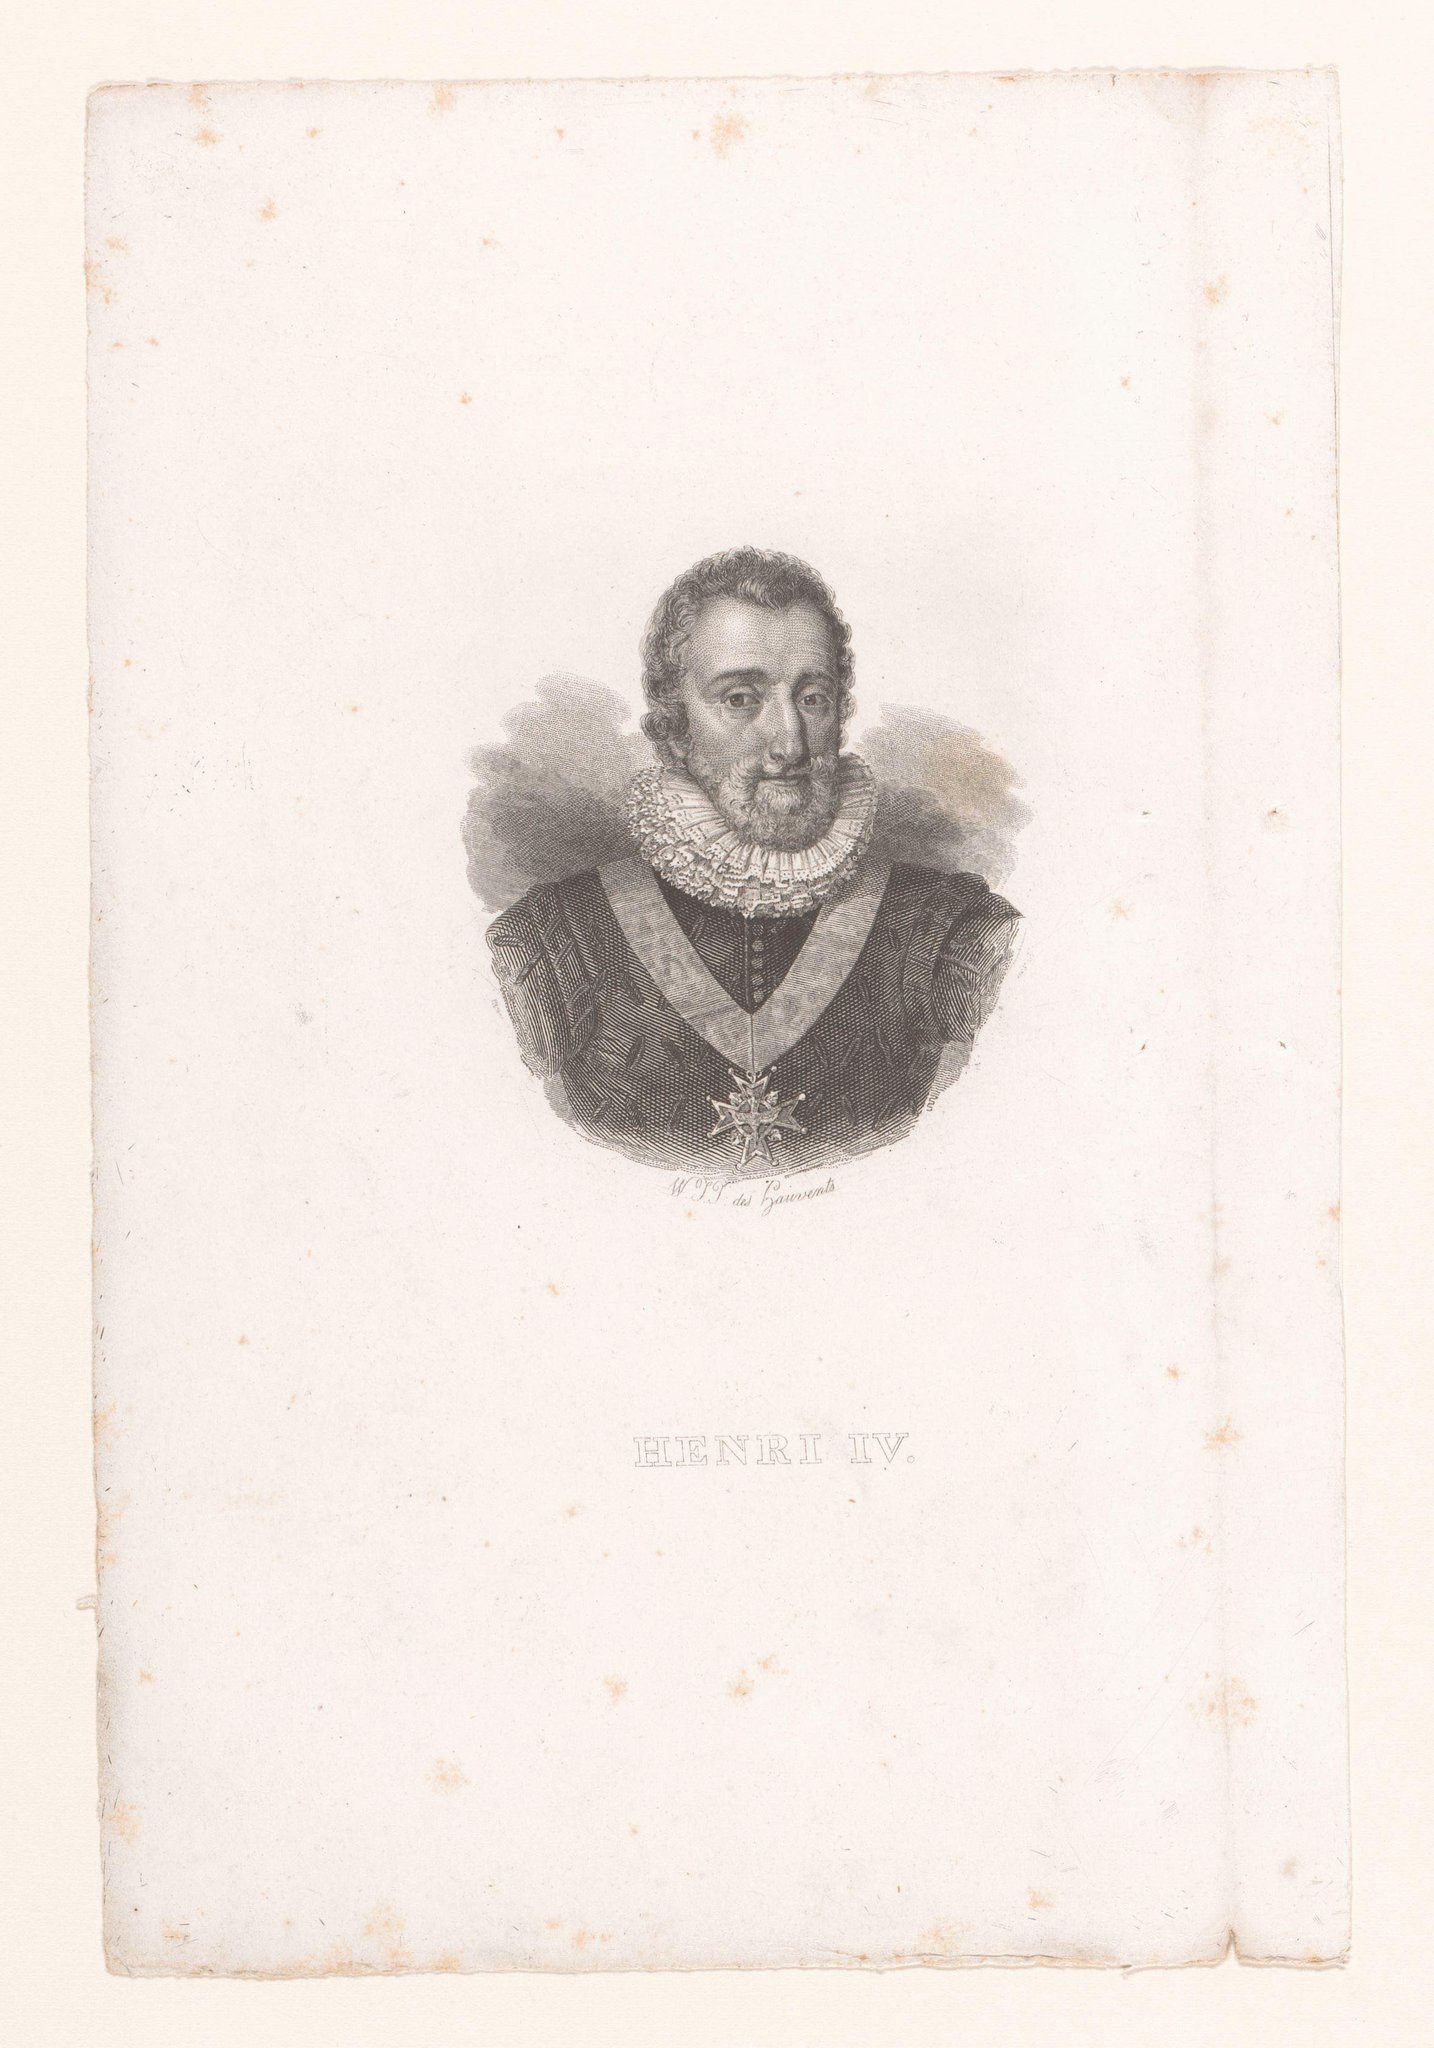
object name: print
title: Portret van Henry de Bourbon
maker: w.j.j.des hauvents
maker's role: print maker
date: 1850-1910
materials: paper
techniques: engraving, etching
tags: paris, adult man, historical persons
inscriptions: collector's mark: Lugt 2228